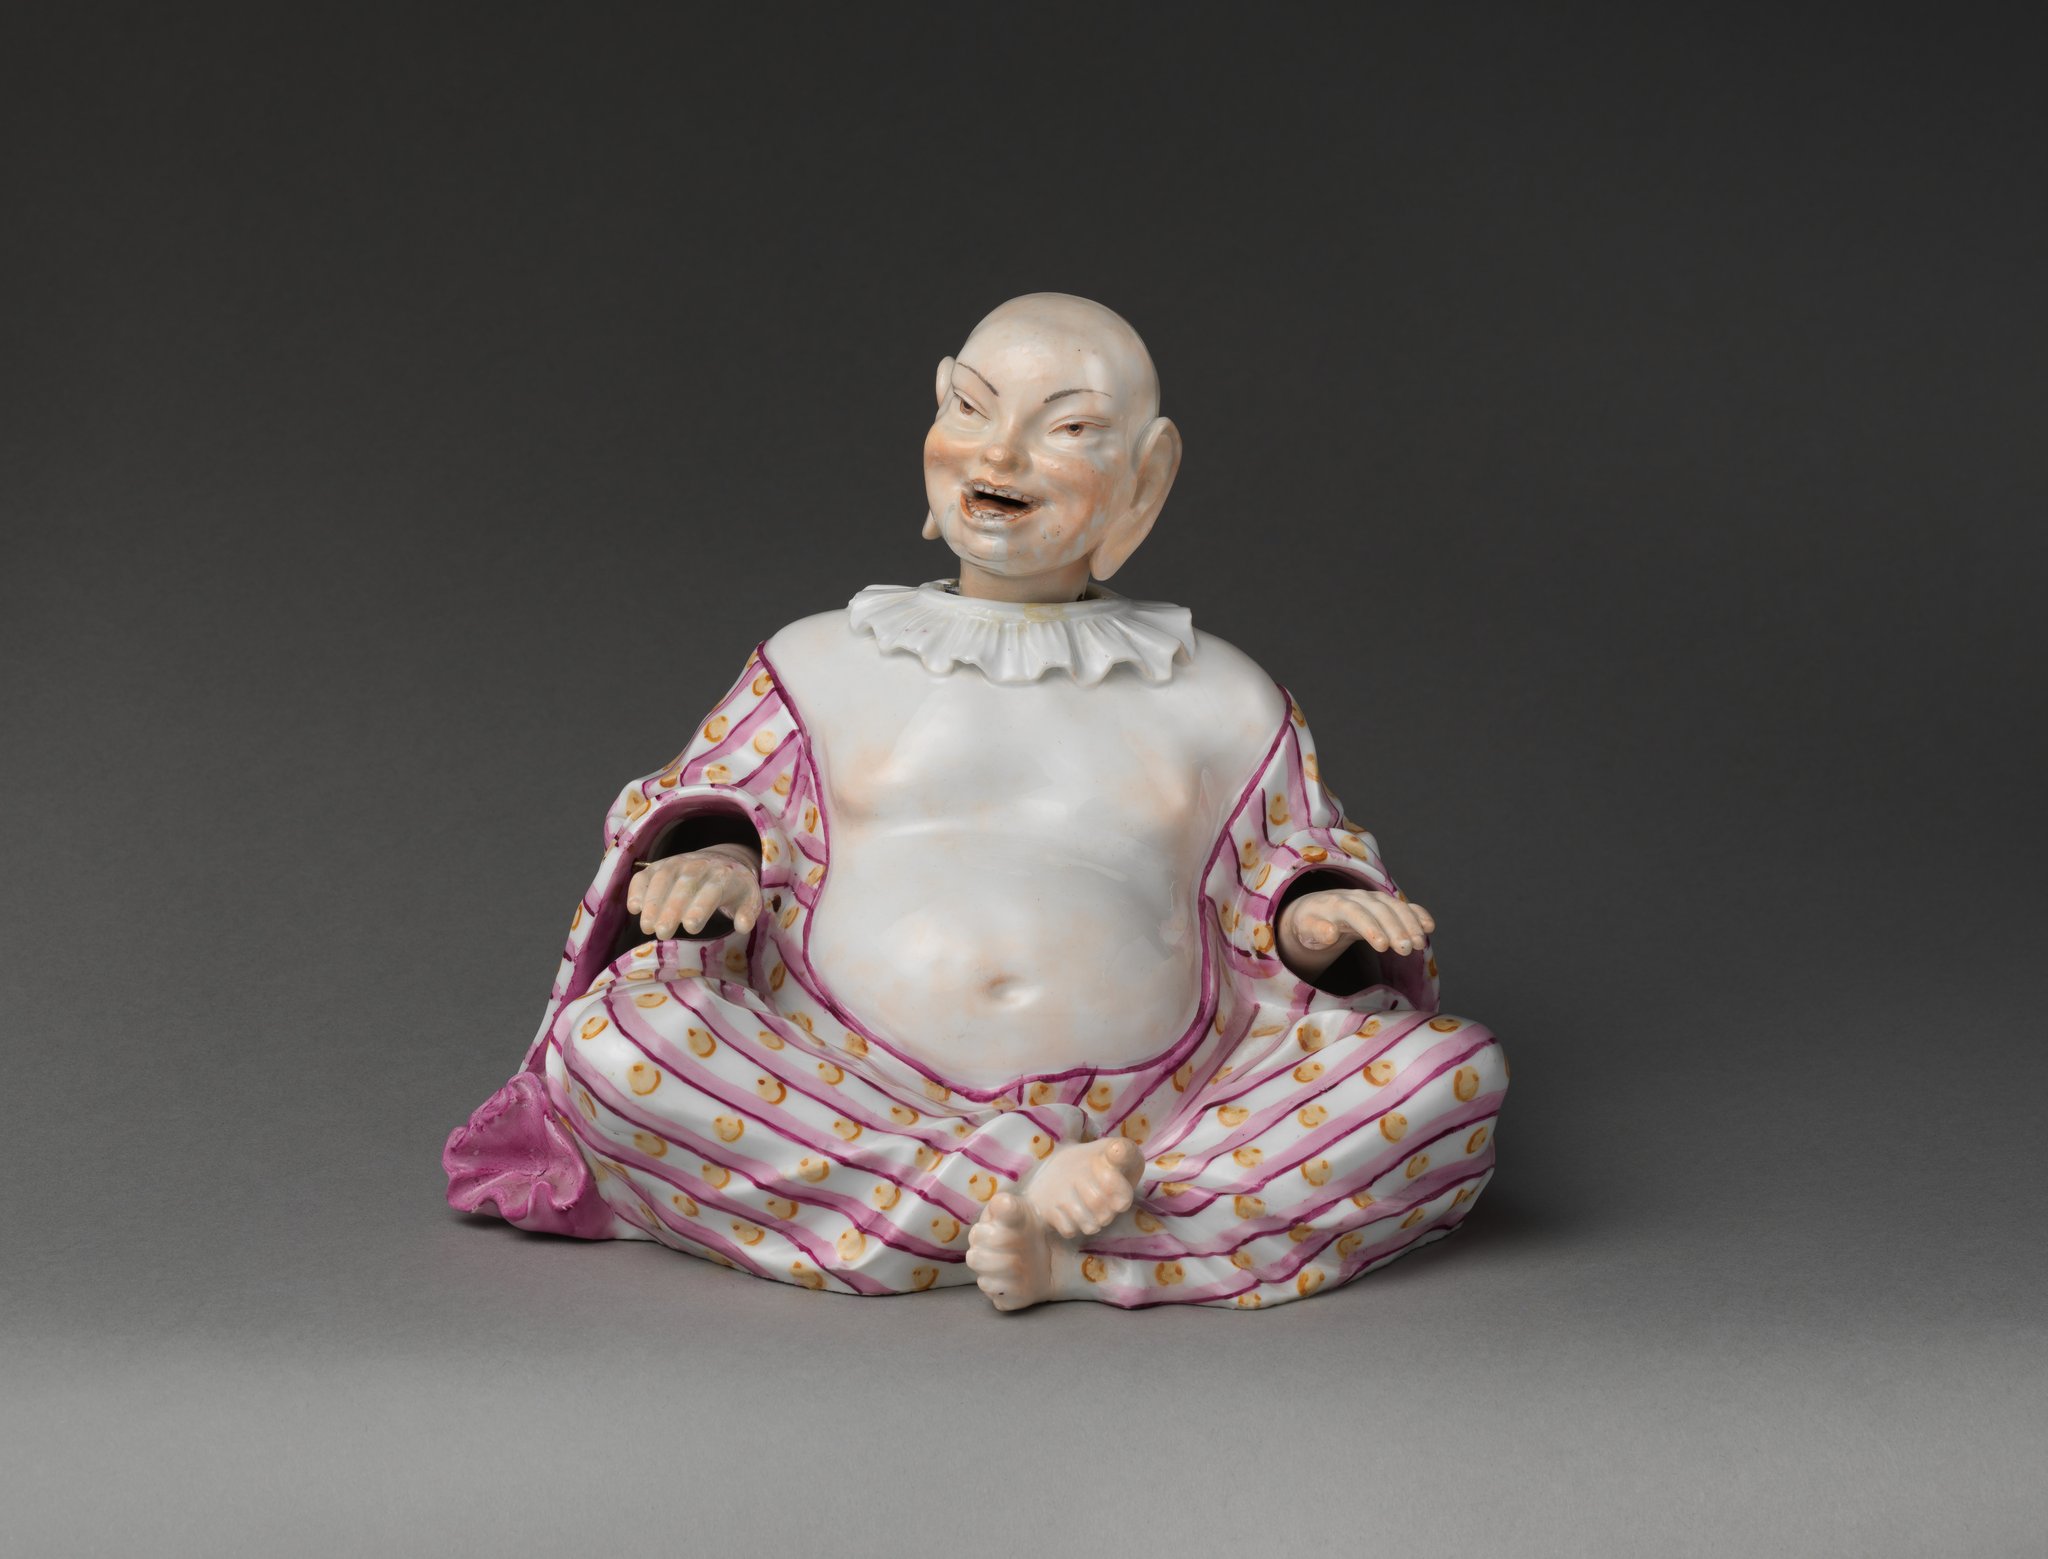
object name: figure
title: Nodding Pagod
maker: meissen manufactory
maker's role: manufactory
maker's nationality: german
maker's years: 1710-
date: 1760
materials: hard paste porcelain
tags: men